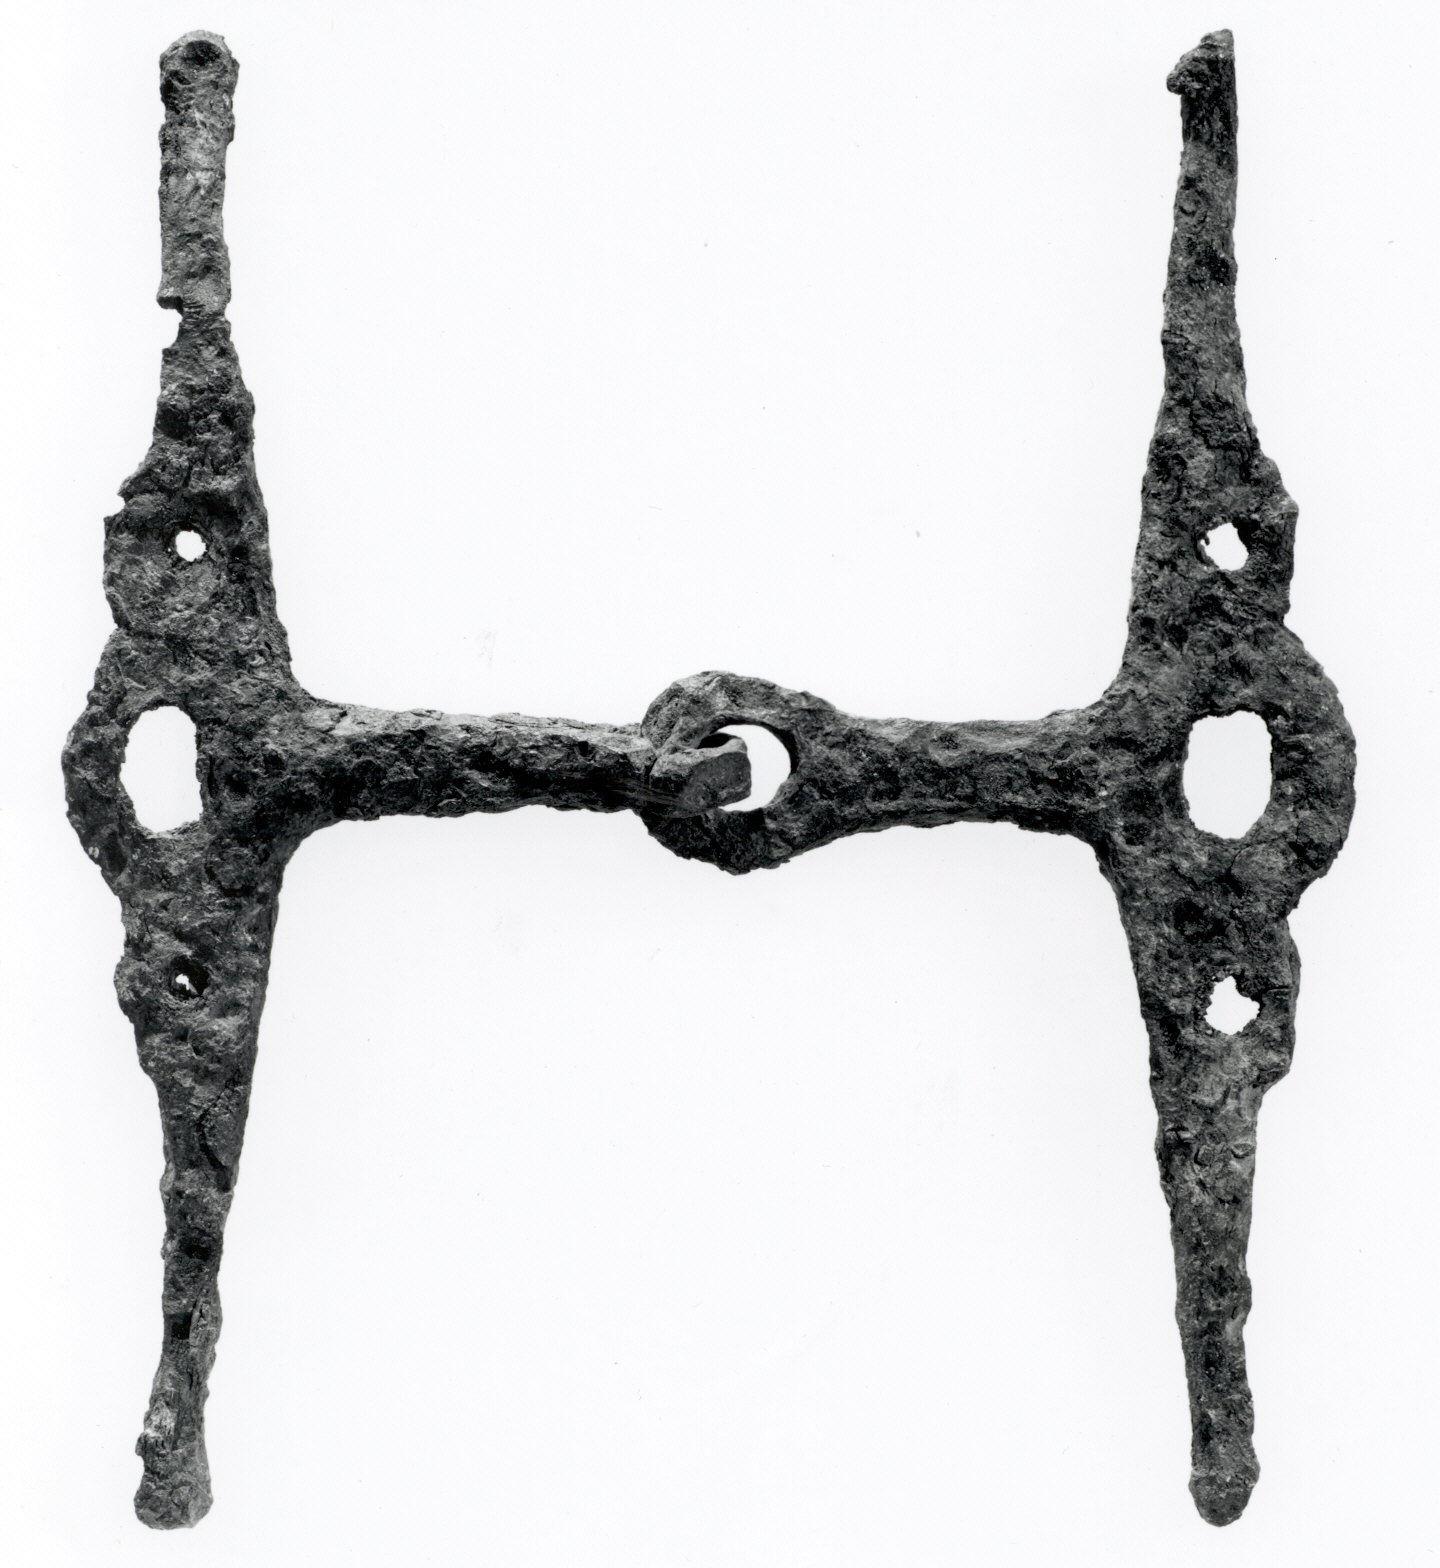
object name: horse bit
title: Horse bit with attached cheekpieces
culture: iranian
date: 800-601 BCE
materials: iron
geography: iran